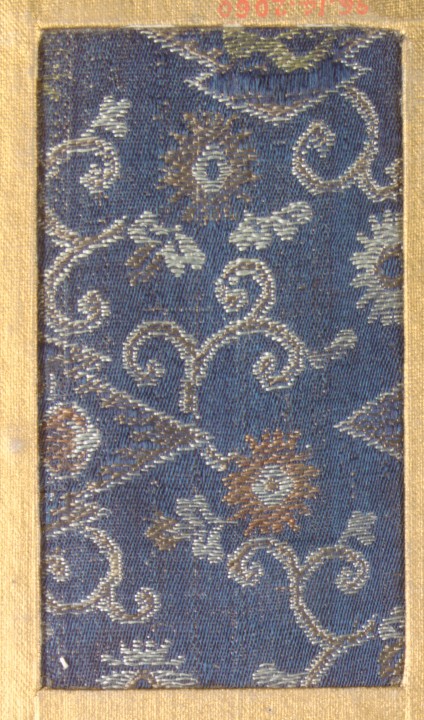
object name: piece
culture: japanese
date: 1701-1900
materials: silk